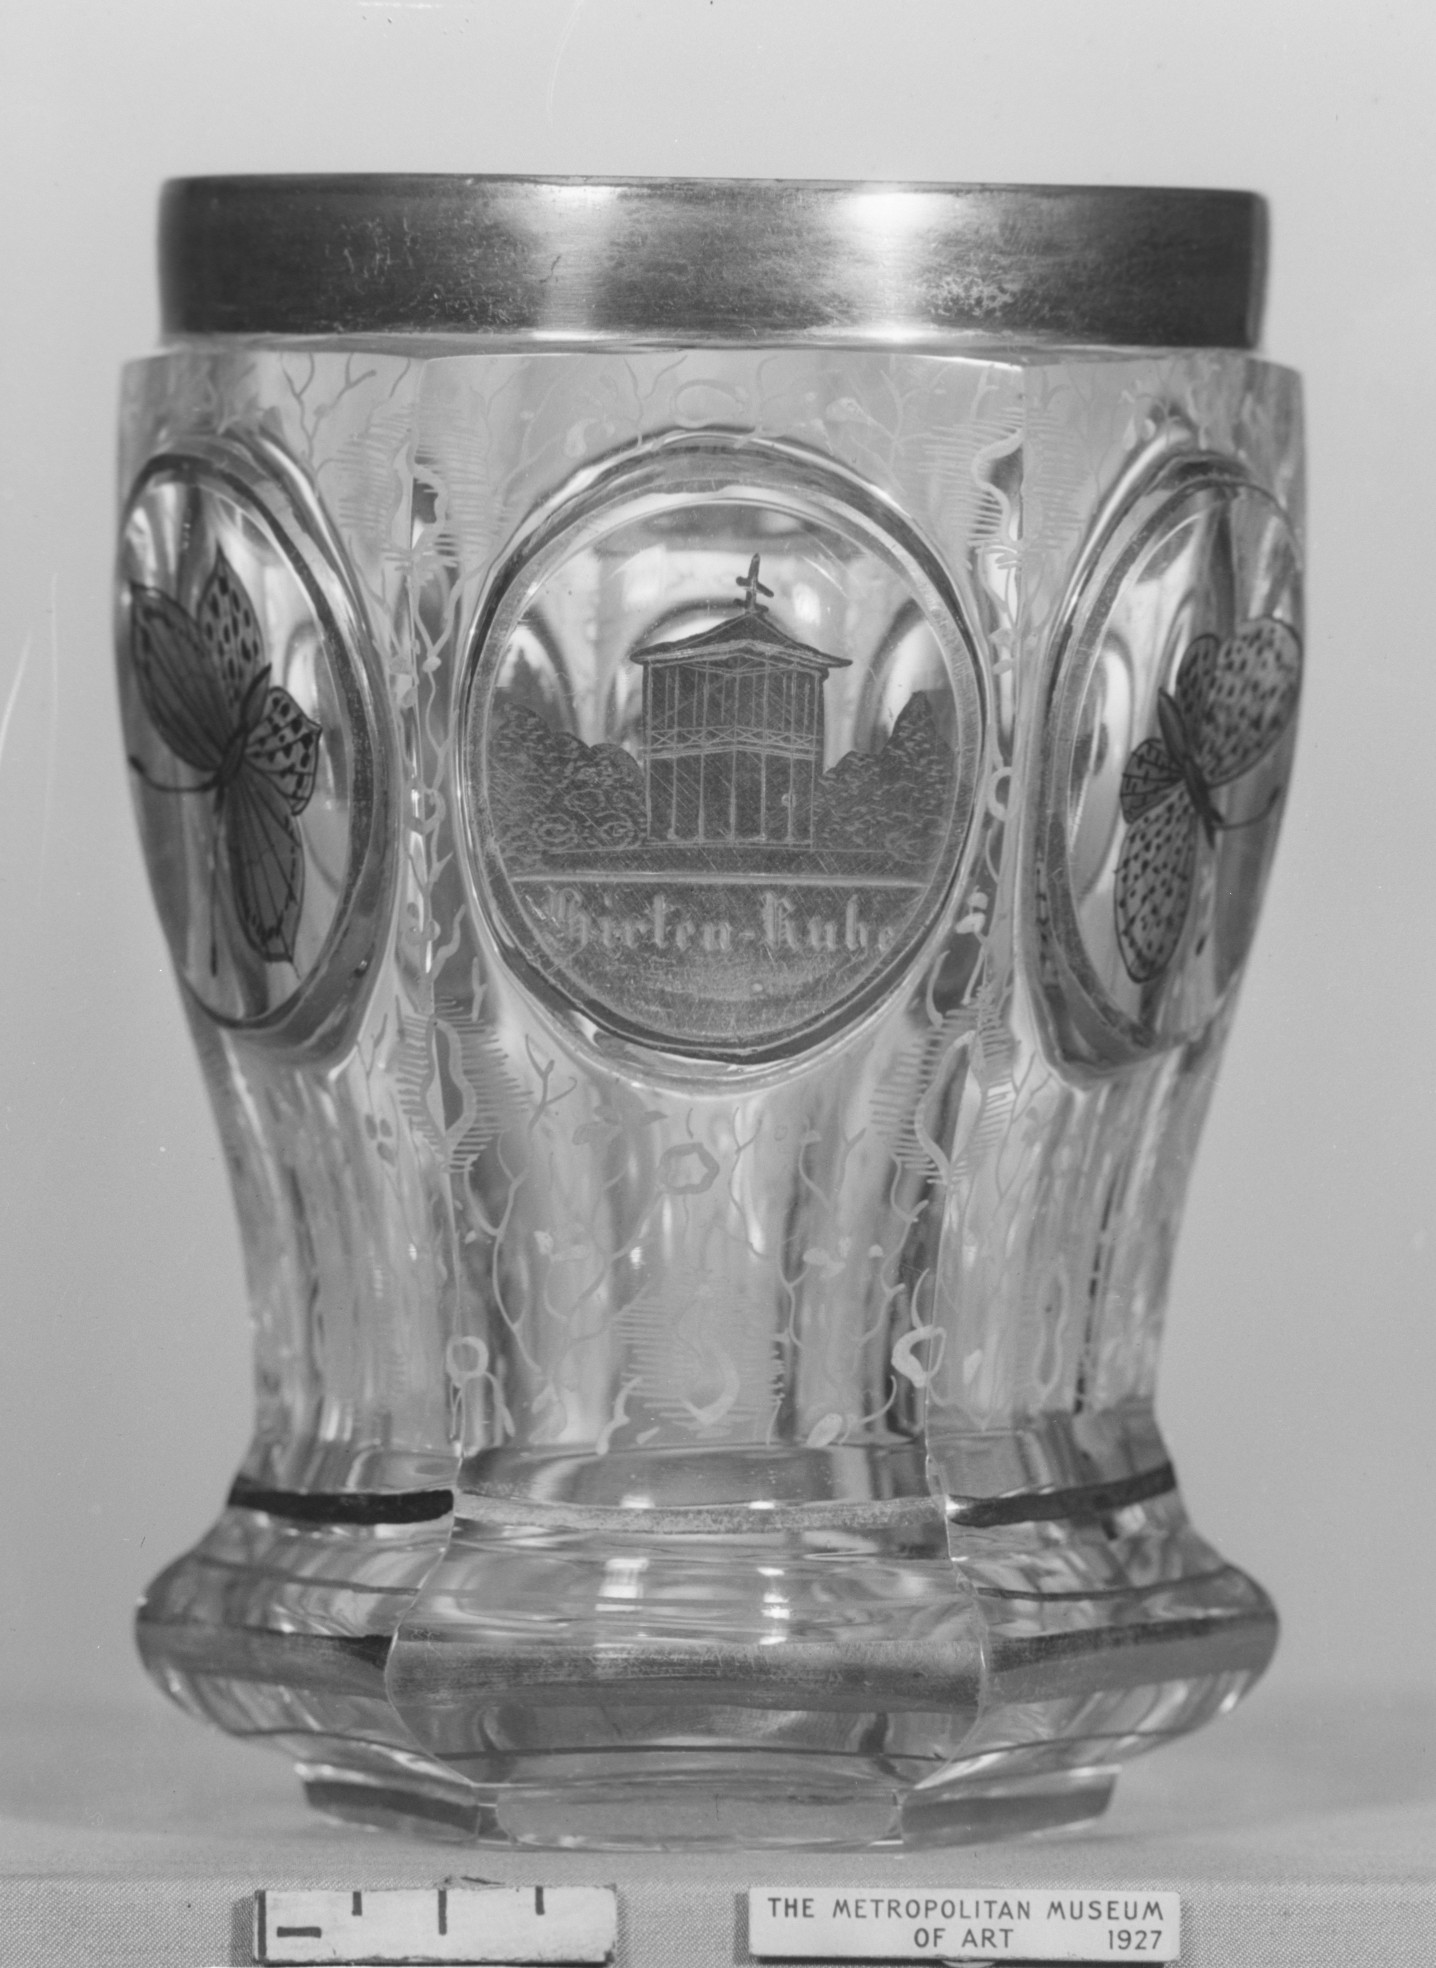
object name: spa beaker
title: Spa beaker with scenes of Marienbad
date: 1840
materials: glass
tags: buildings,butterflies